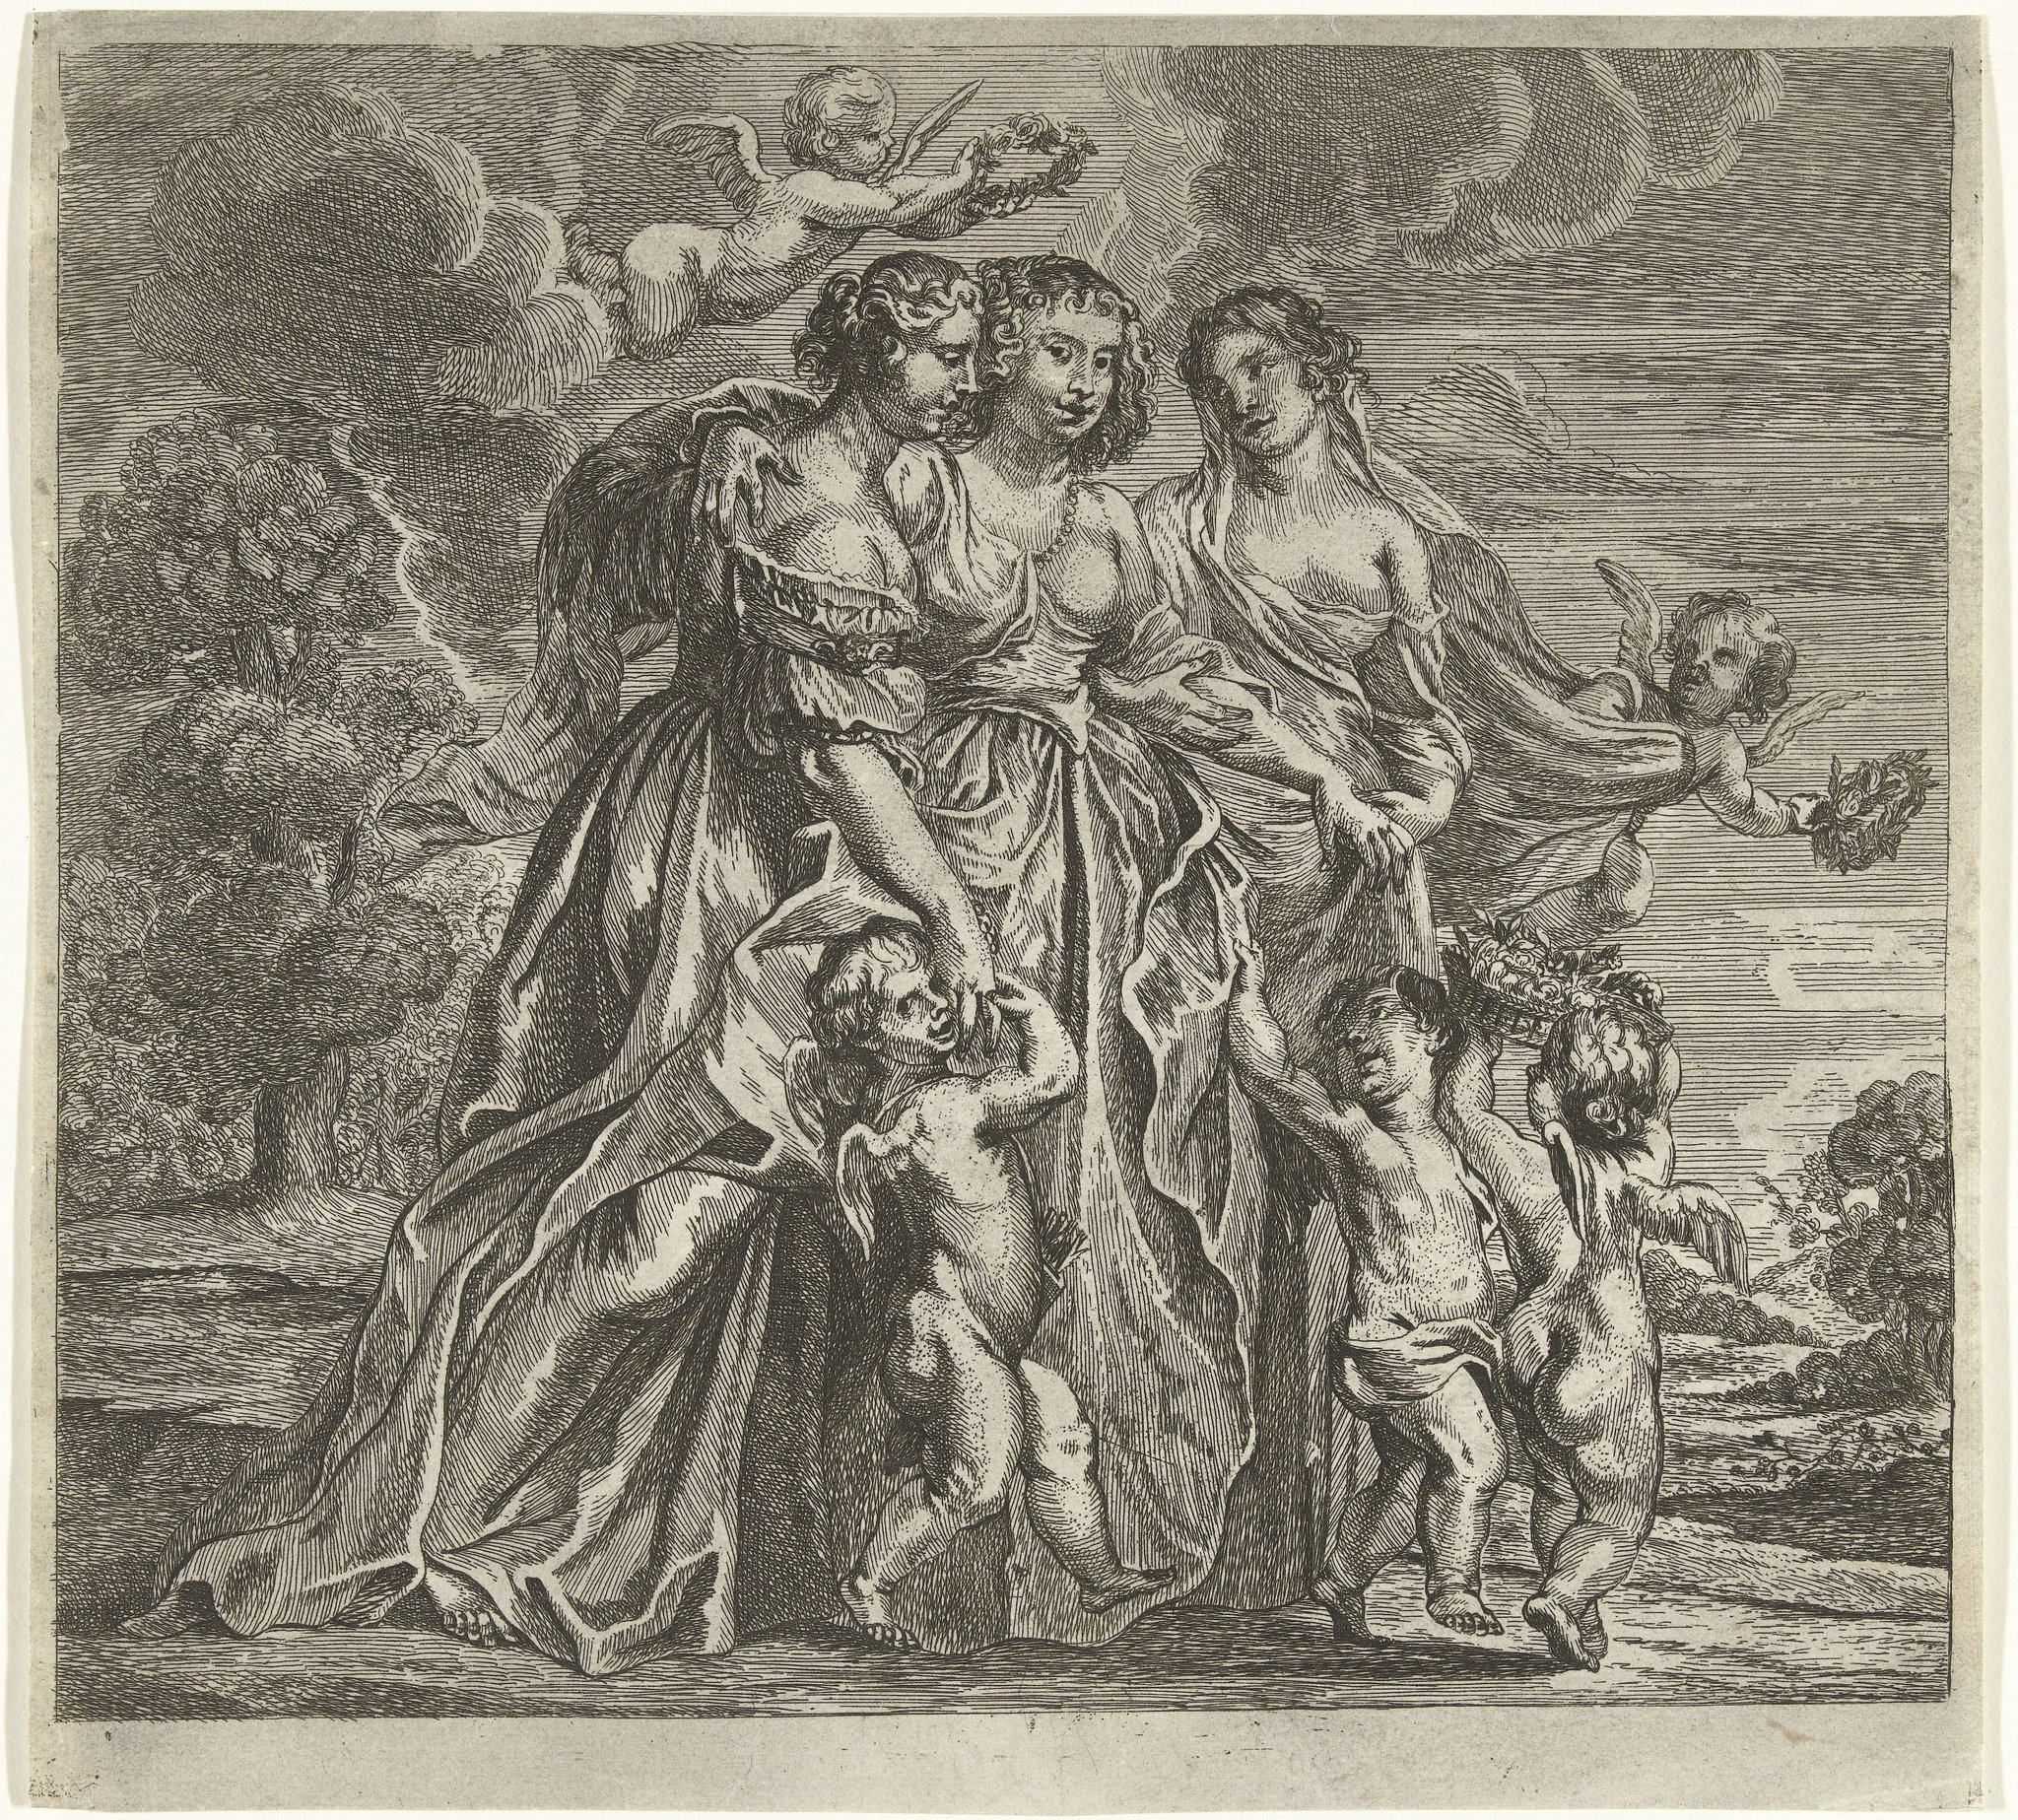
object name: print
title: Drie gratiën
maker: remoldus eynhoudts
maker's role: print maker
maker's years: 1613-1680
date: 1626-1680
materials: paper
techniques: etching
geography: antwerp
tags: graces (charites), generally three in number; 'gratie' (ripa)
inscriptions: collector's mark: Lugt 240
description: De drie gratiën vergezeld van vijf putti waarvan één met een bloemenmand en twee met bloemenkransen.